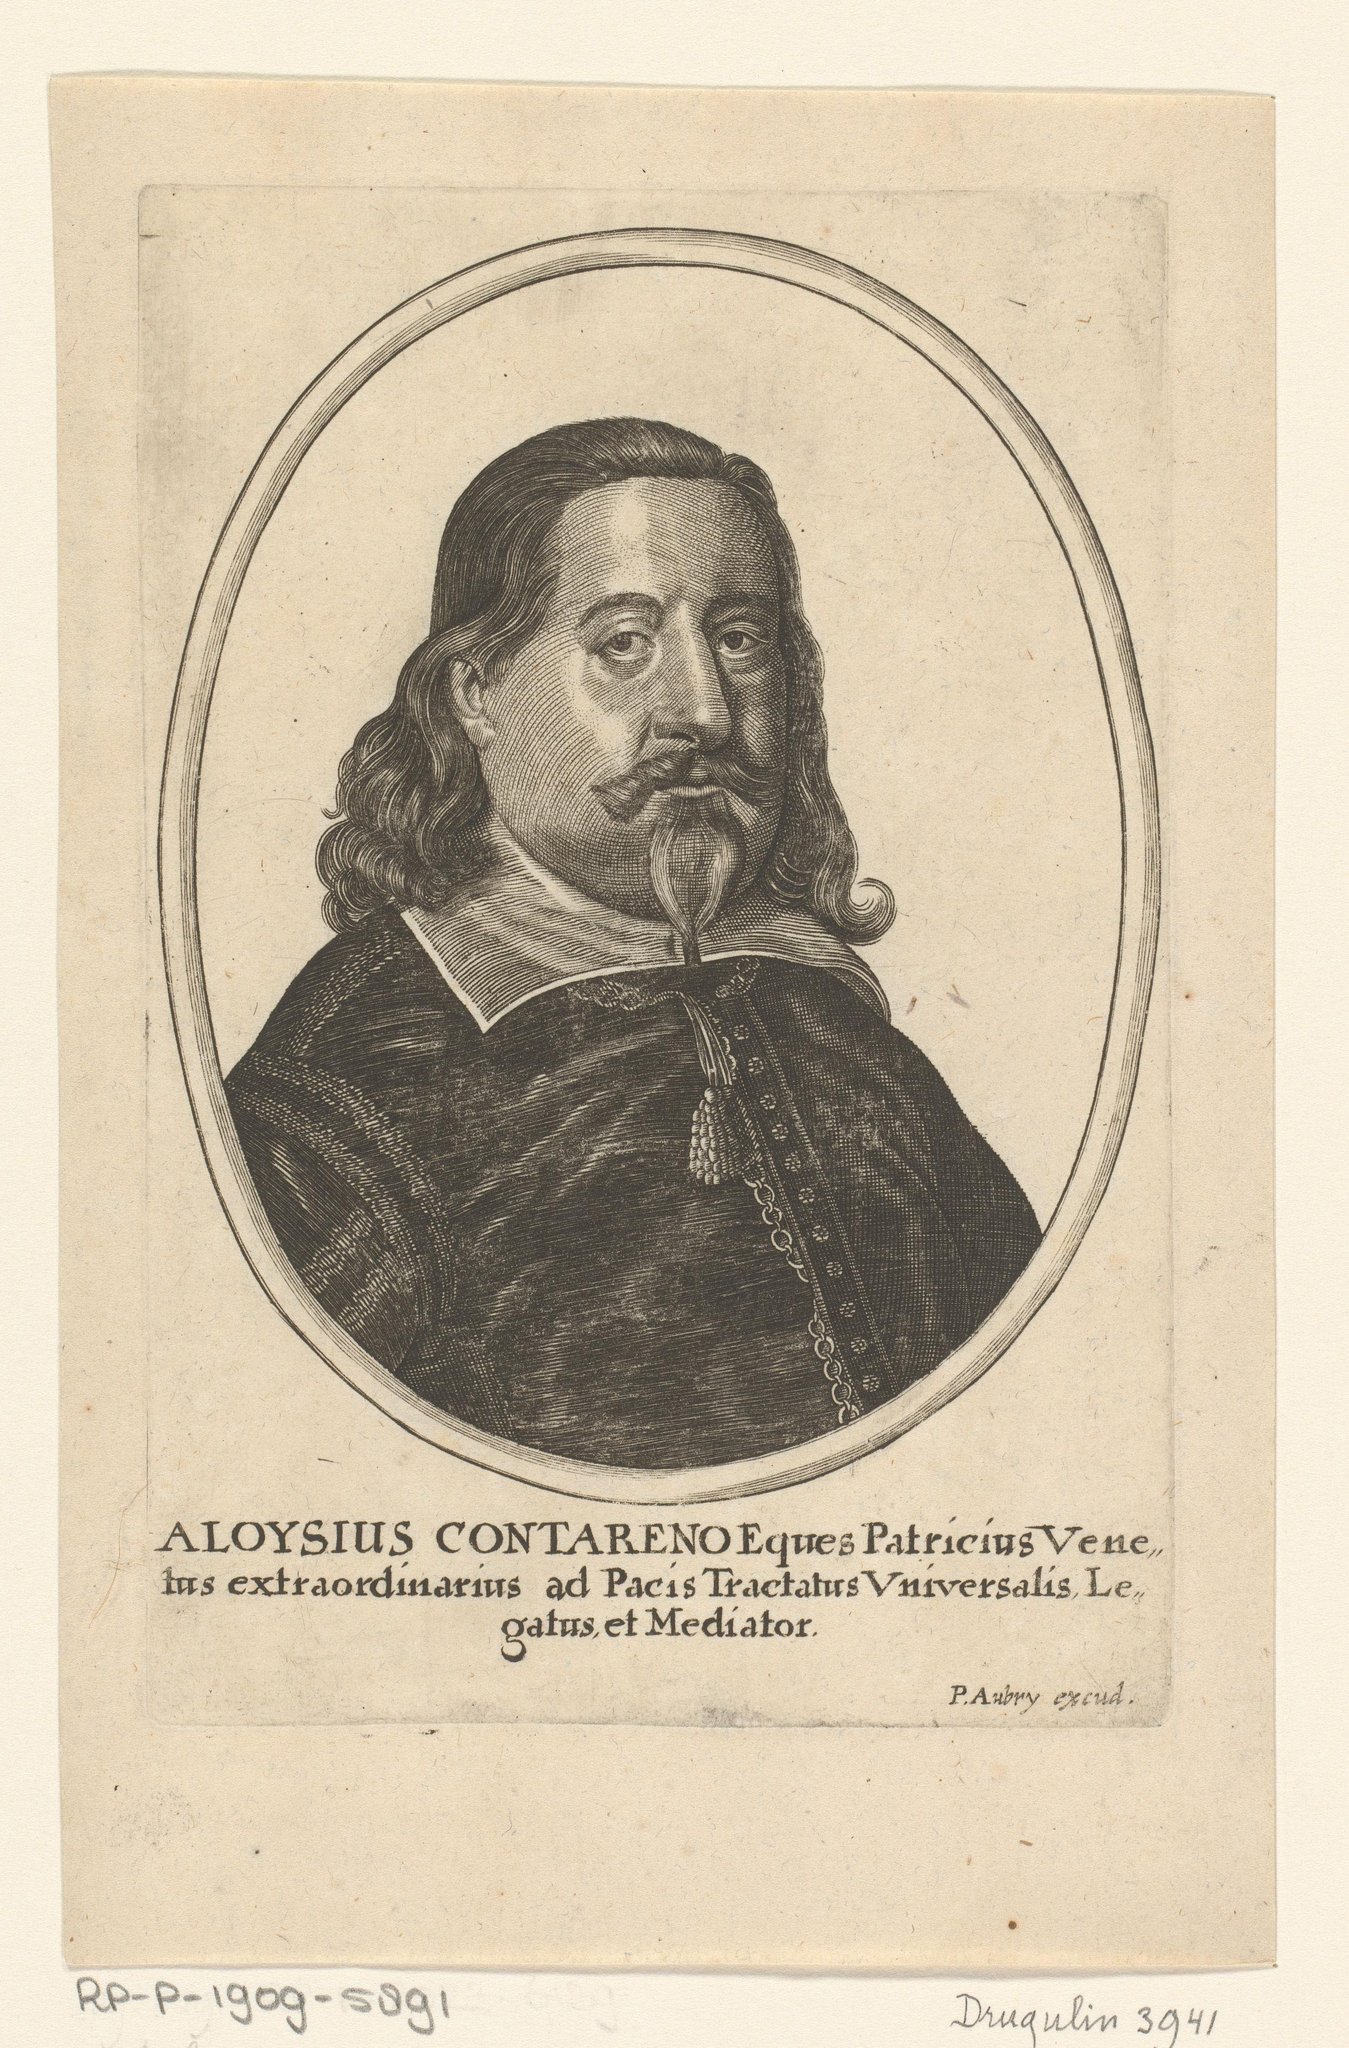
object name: print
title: Portret van Aloysius Contareno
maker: Anonymous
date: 1648-1650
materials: paper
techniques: engraving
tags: historical persons, diplomacy, diplomat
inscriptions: collector's mark: Lugt 2228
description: Met drieregelig onderschrift in het Latijn.